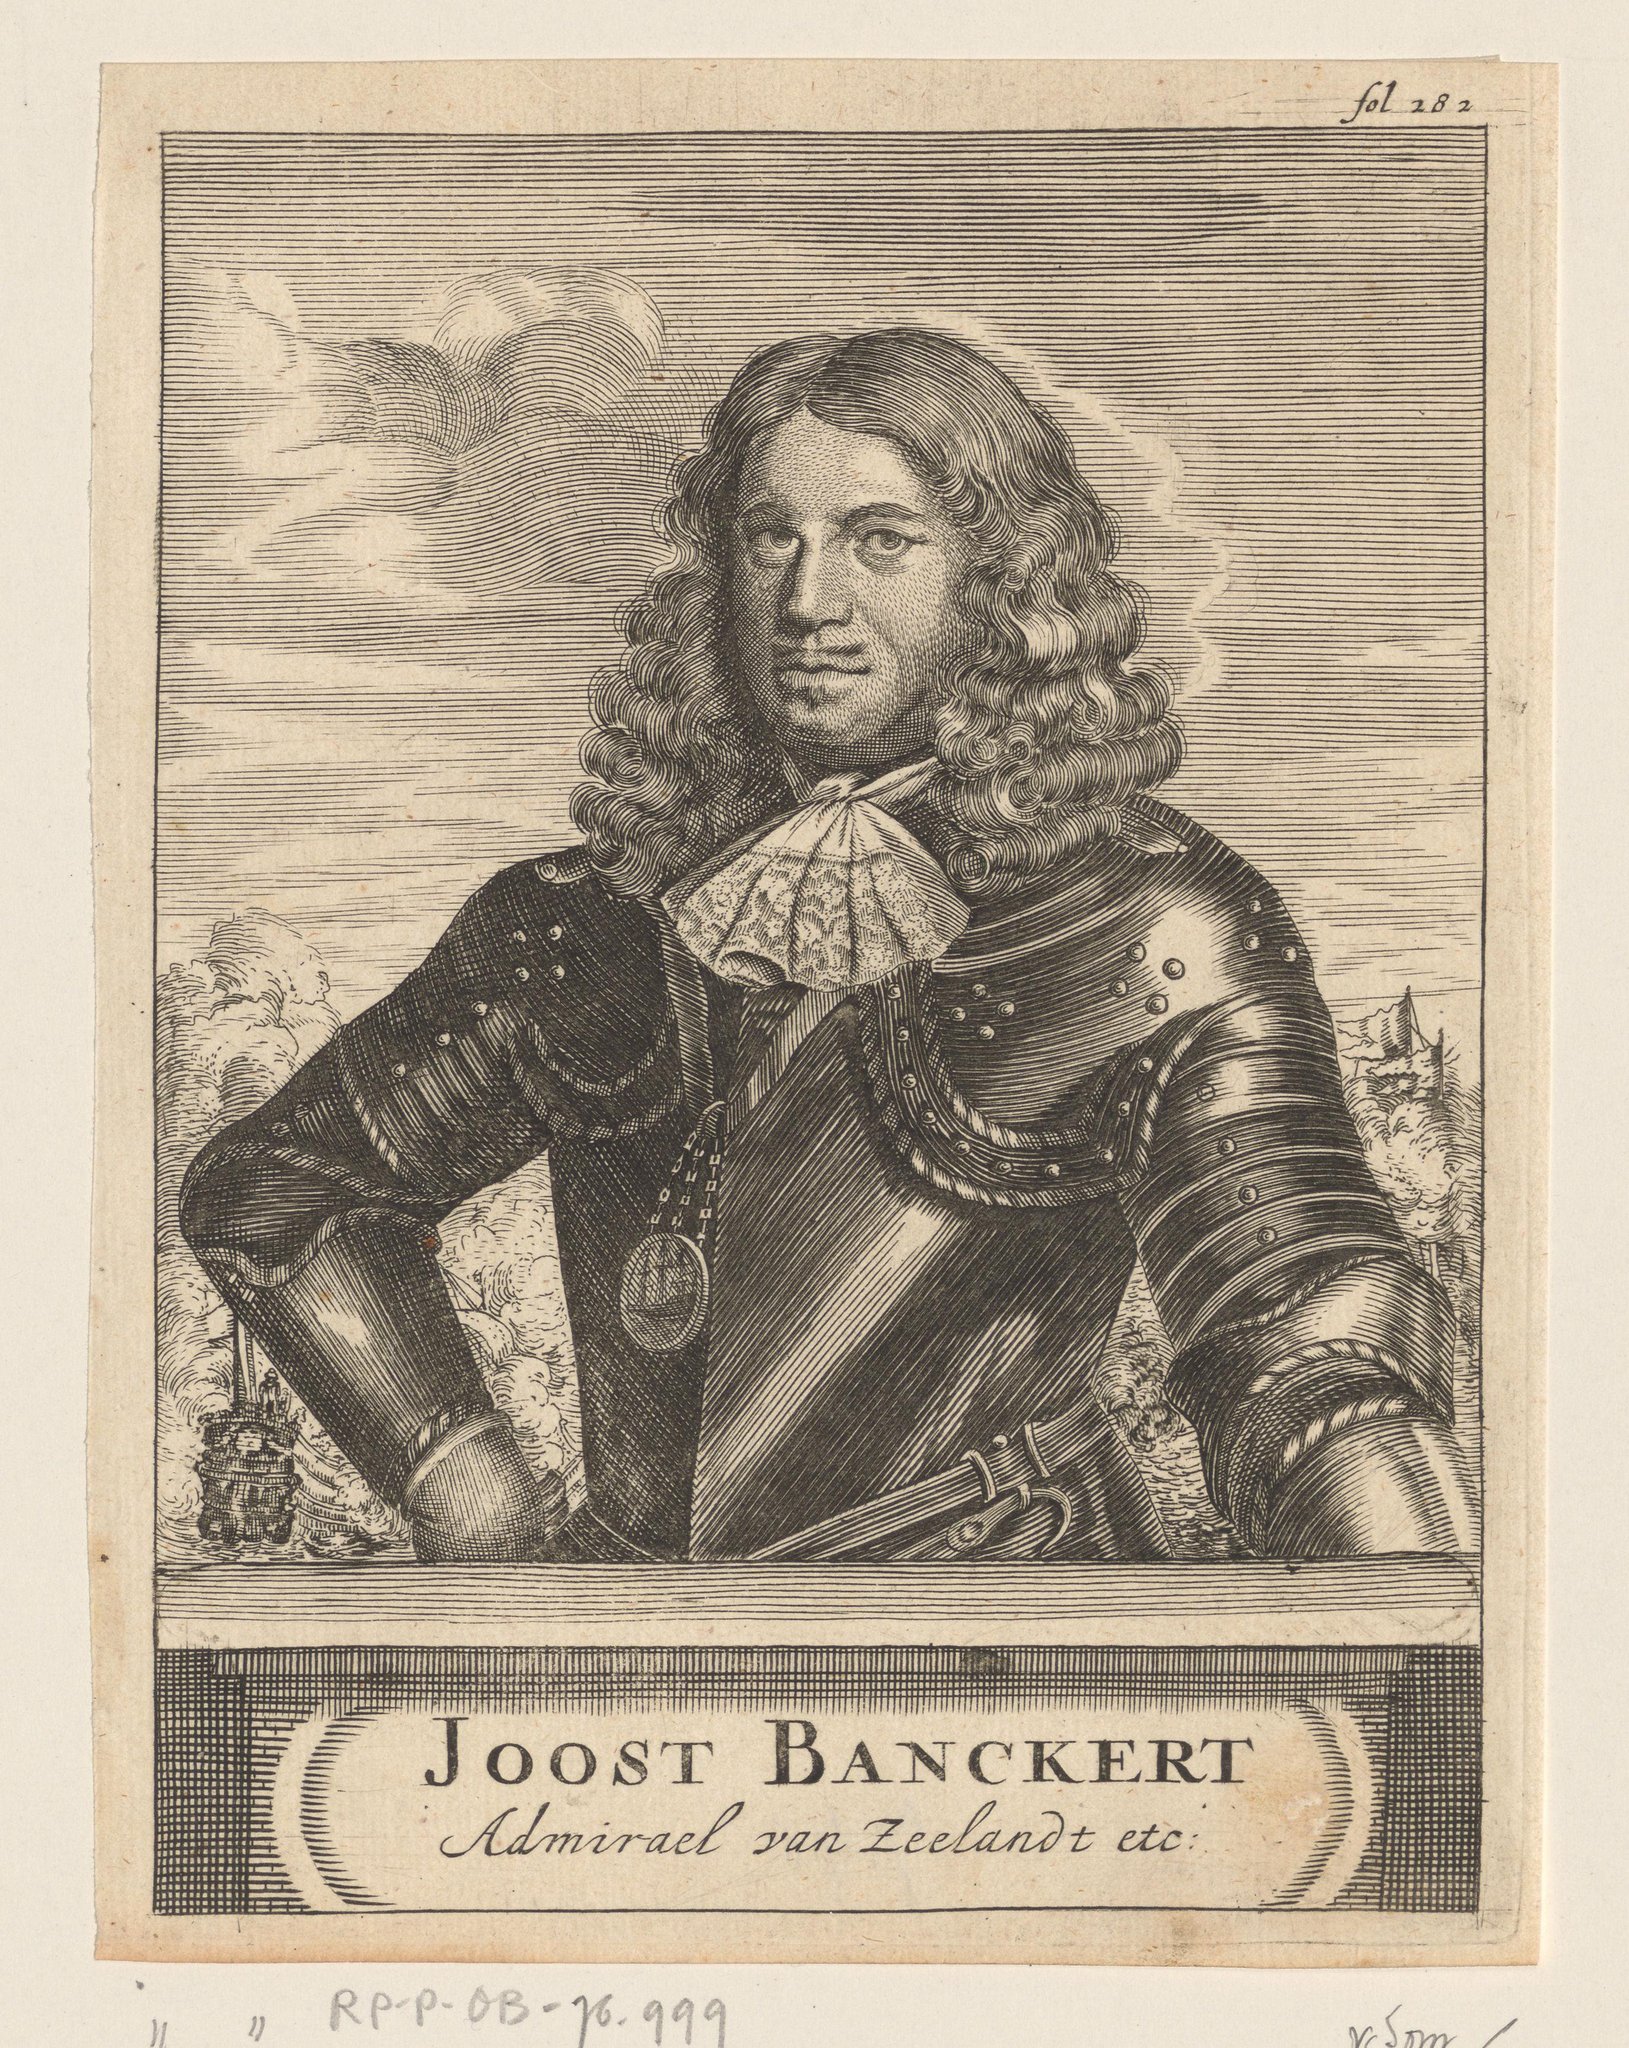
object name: print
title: Portret van Joost Banckert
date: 1683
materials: paper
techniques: engraving, etching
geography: amsterdam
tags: flushing, commander-in-chief, general, marshal, armour, historical persons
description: Prent uit: Bos, Lambert van den. Leeven en daaden der doorluchtigste zee-helden. Amsterdam: Jan Claesz. ten Hoorn en Jan Bouman, 1683.